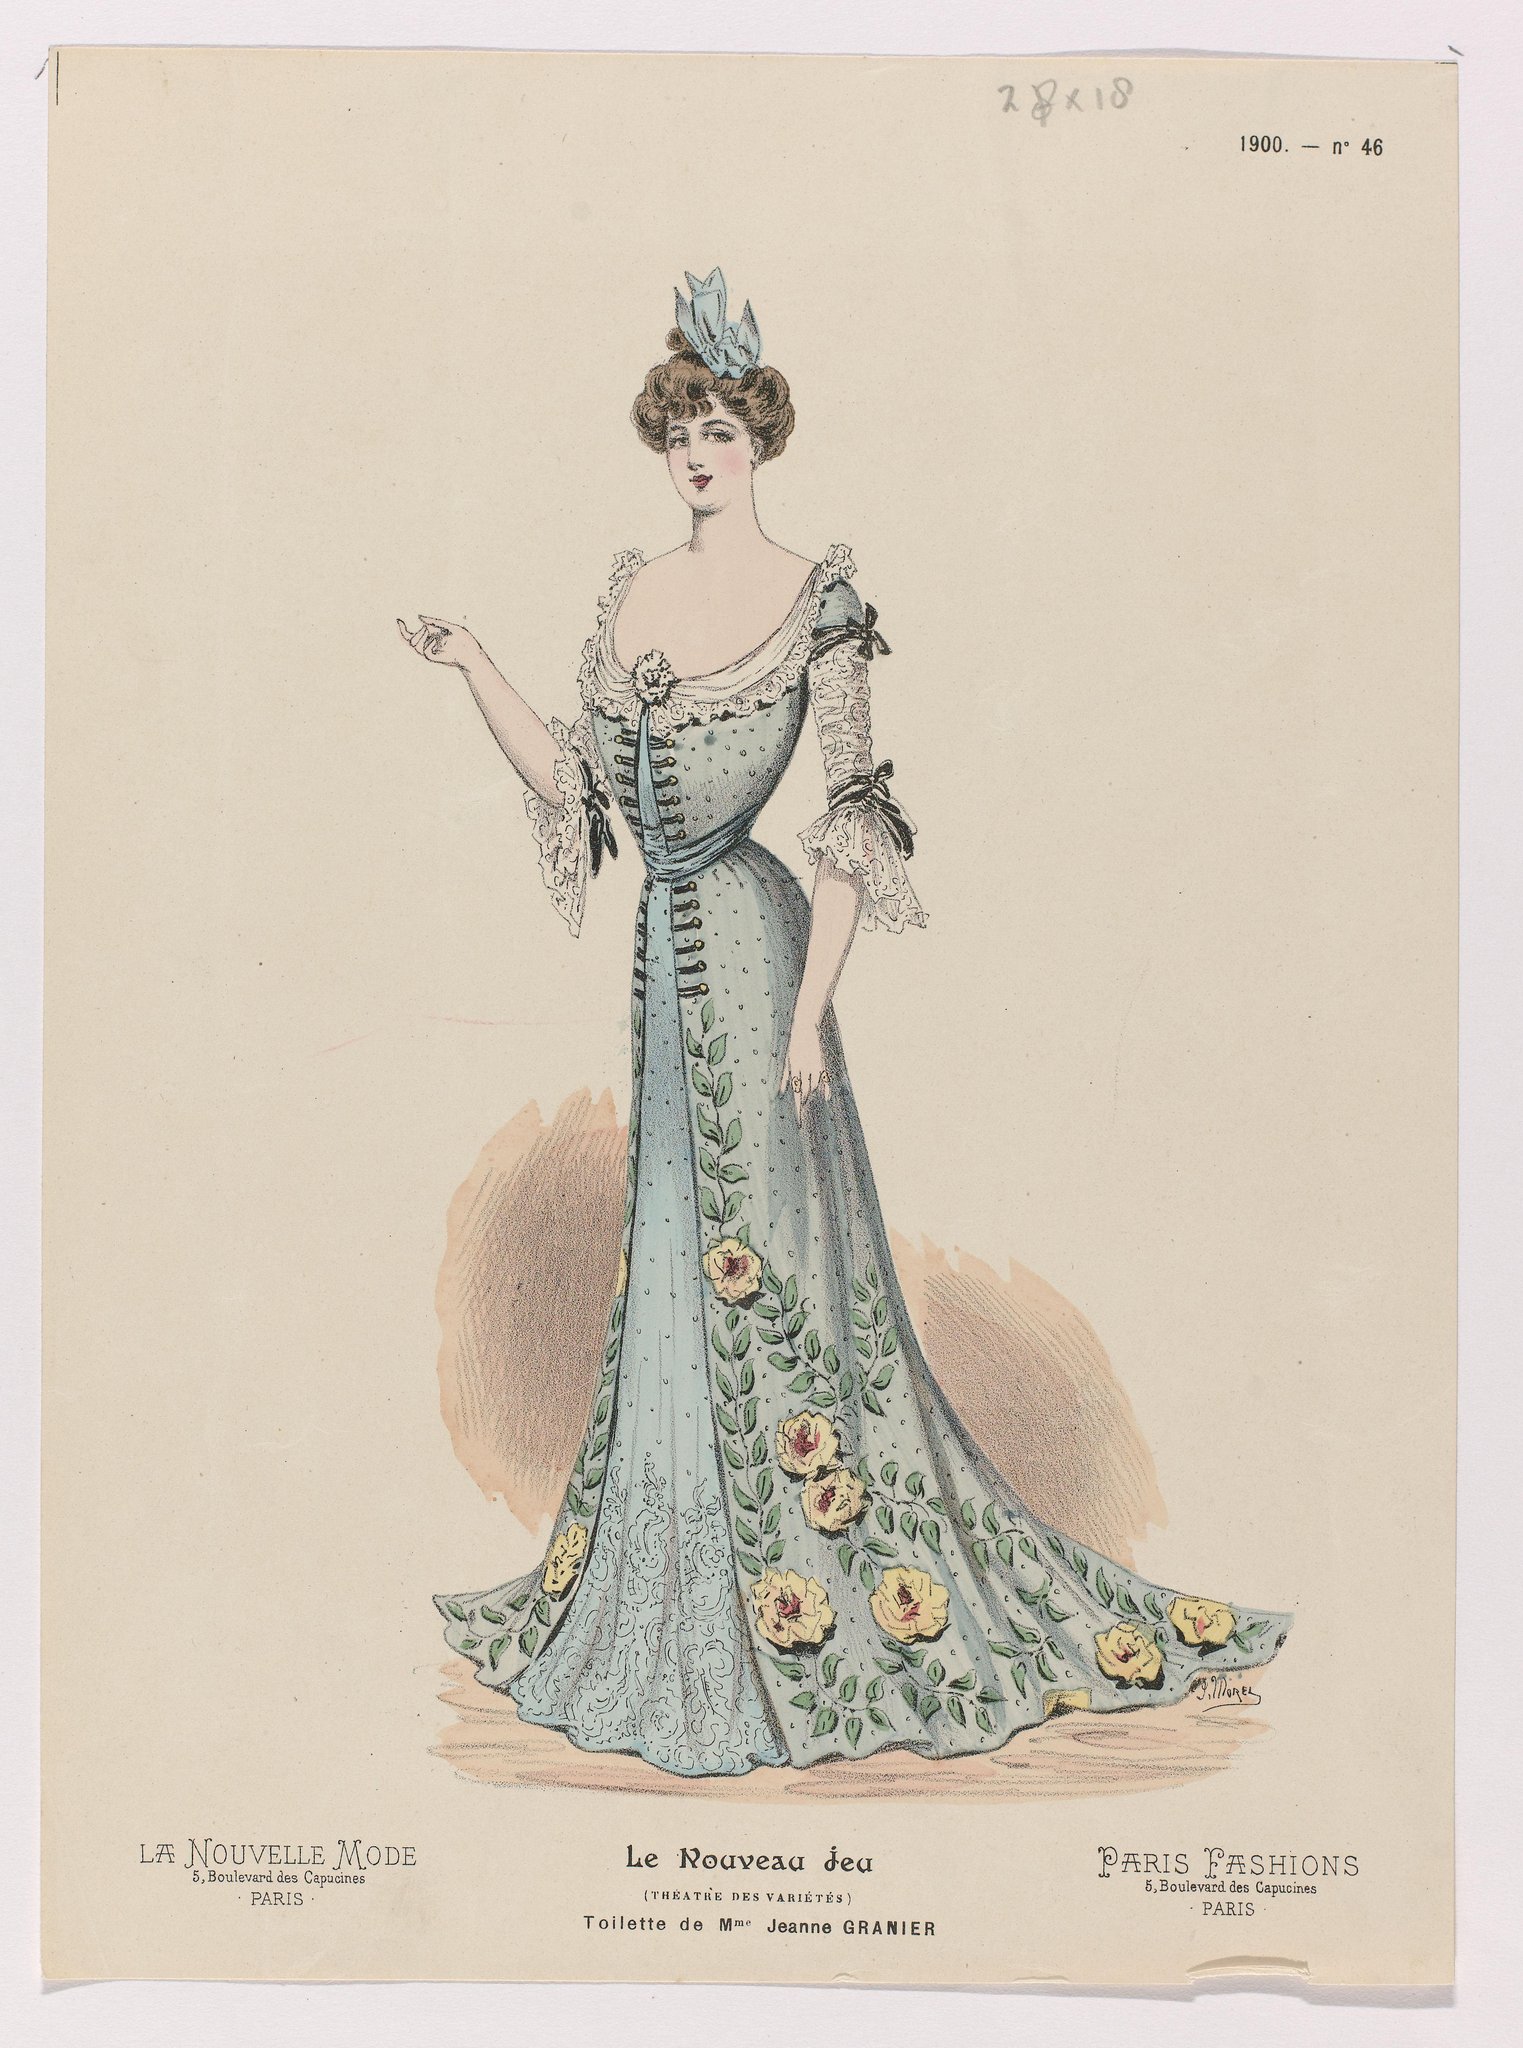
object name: fashion print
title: La Nouvelle Mode, Le Nouveau jeu, Paris Fashions, 1900, No. 46 : Toilette de Mme Jeanne Granier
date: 1900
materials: paper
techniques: hand coloring, lithograph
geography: paris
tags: bow (ornamental part of clothing) (+ women's clothes), dress, gown: evening dress (+ women's clothes), fashion plates, dress, gown (+ women's clothes)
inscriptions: address: ‘LA NOUVELLE MODE 5, Boulevard des Capucines PARIS / PARIS FASHIONS 5, Boulevard des Capucines PARIS’, caption: ‘Toilette de Mme Jeanne GRANIER’, title: ‘Le Nouveau jeu (THÉATRE DES VARIÉTÉS)’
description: Japon van Jeanne Granier. De gestippelde japon heeft een lage ronde hals, halflange mouwen en een sleep versierd met een bloem- en bladmotief. Prent uit het modetijdschrift La Nouvelle Mode (1894-1926).